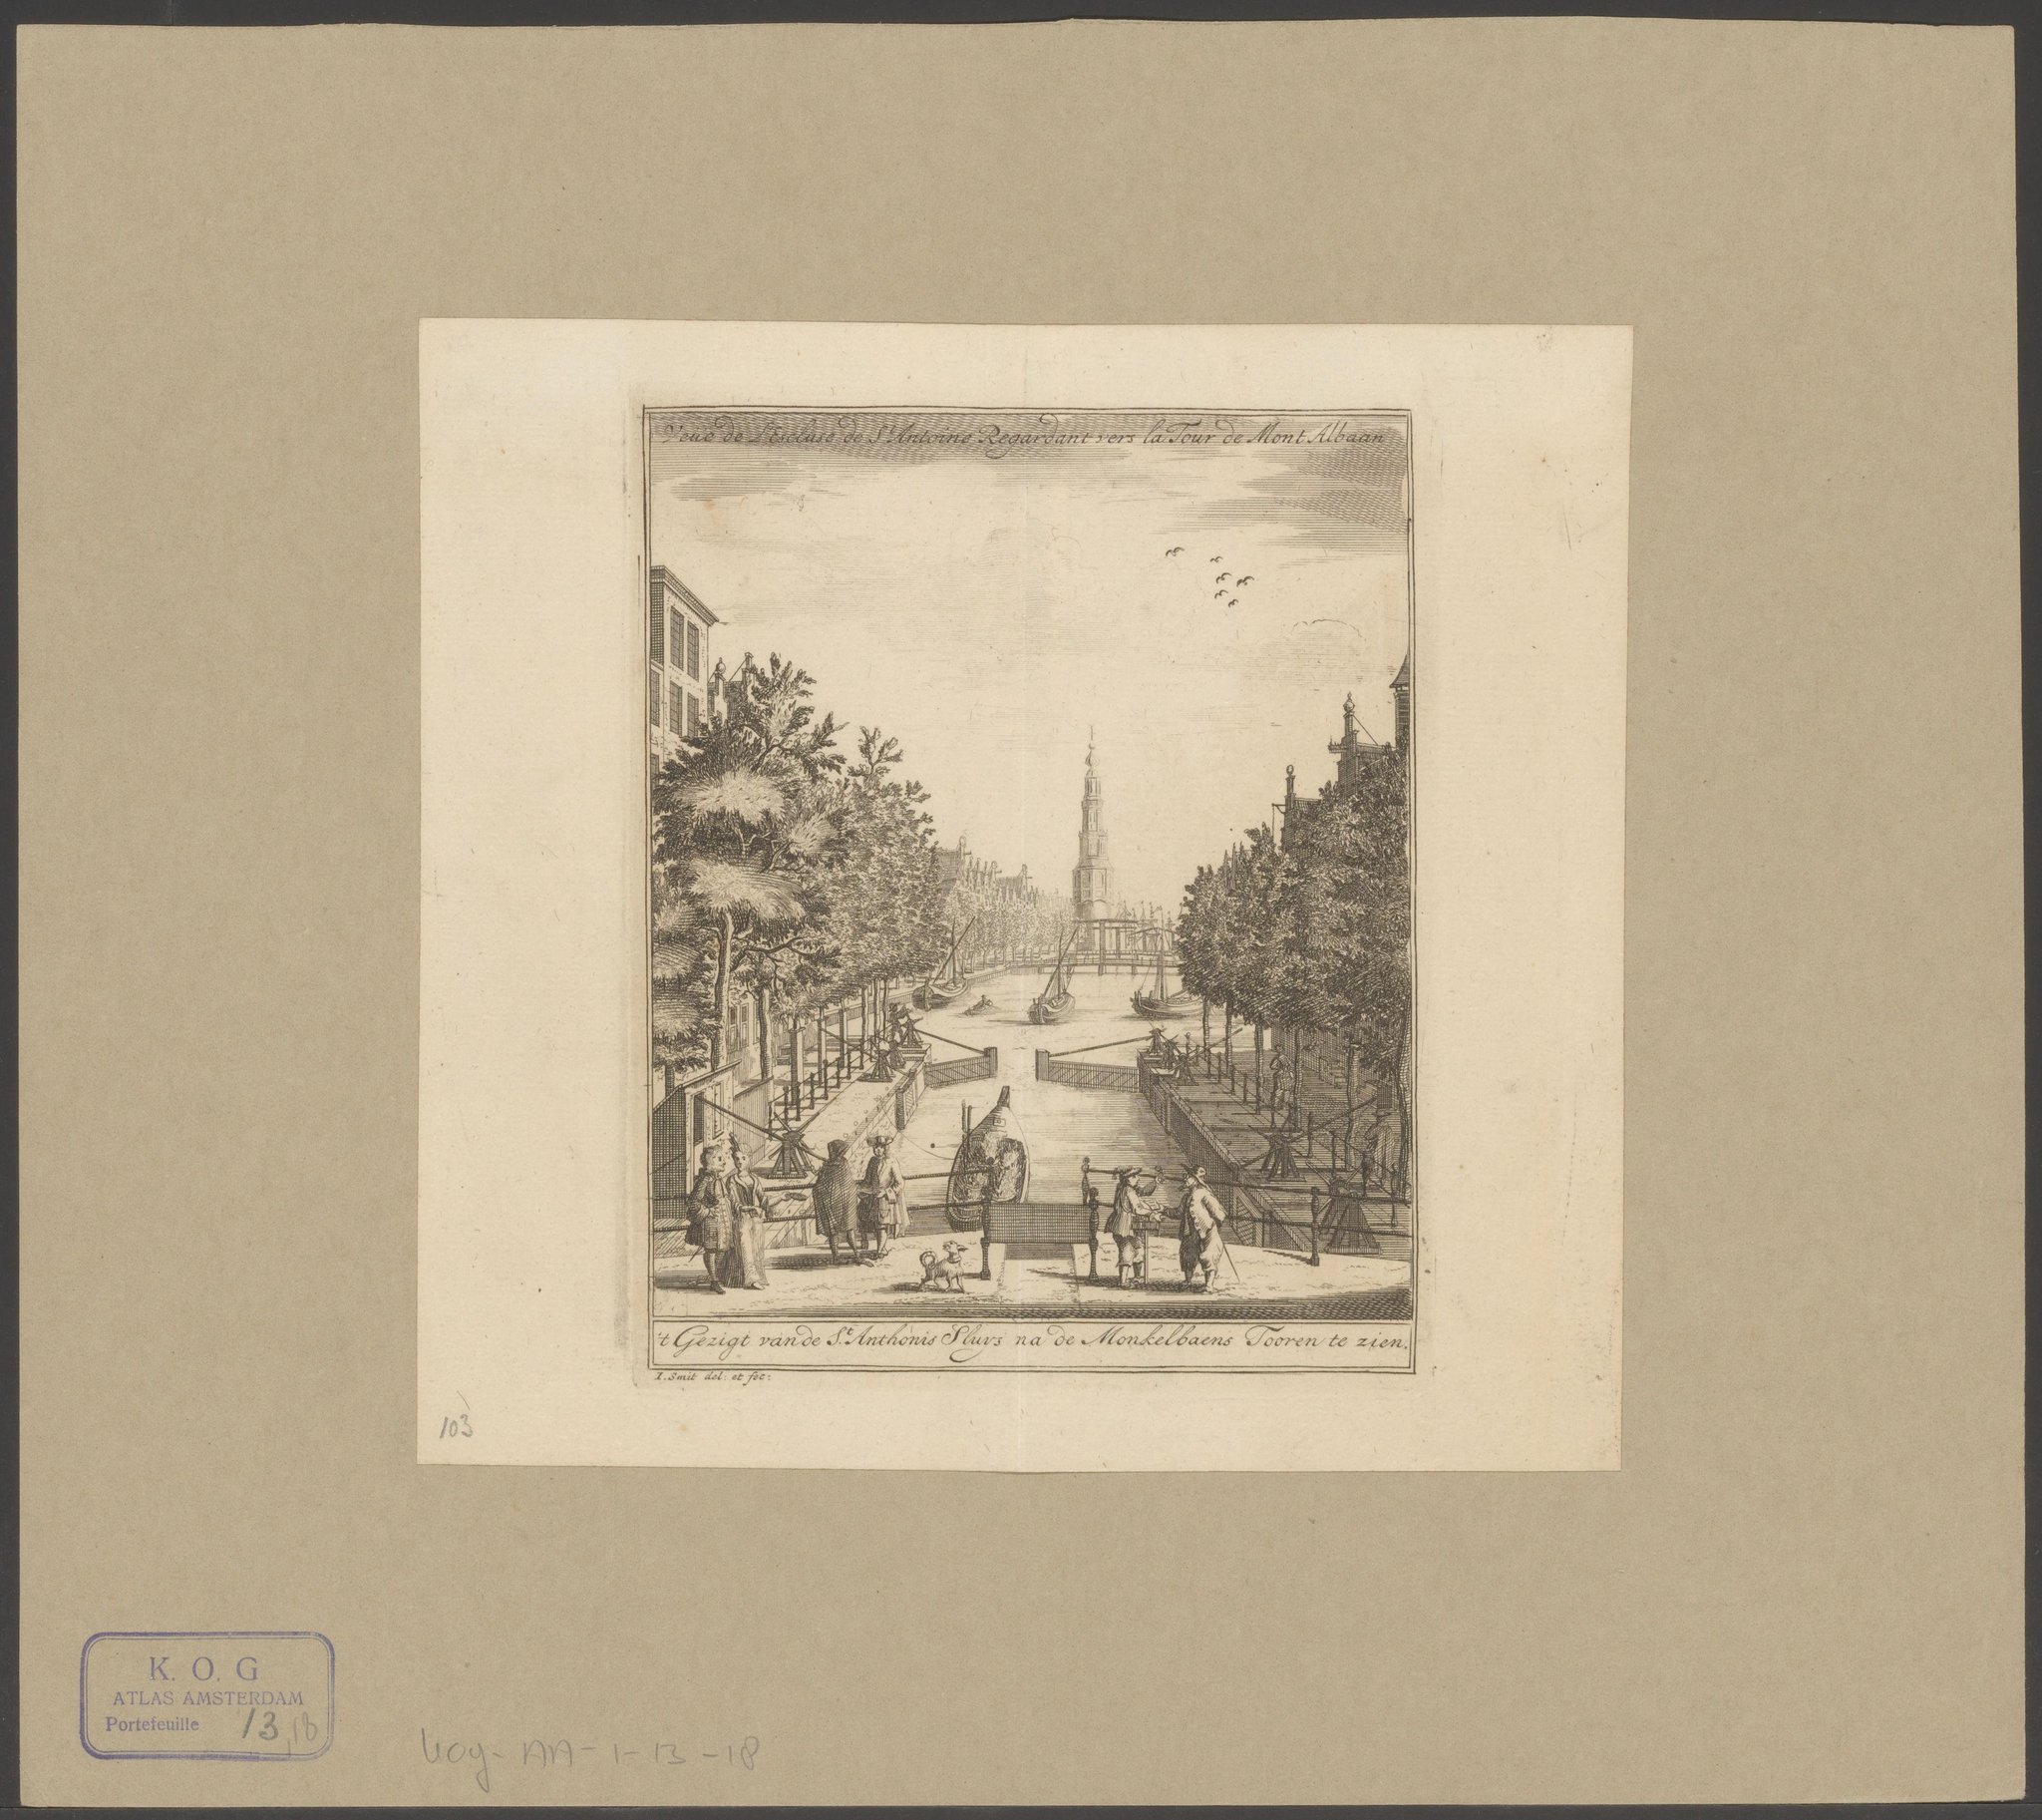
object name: print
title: 't Gezigt van de St. Anthonis Sluys na de Monkelbaens Tooren te zien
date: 1685-1768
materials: paper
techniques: engraving, etching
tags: sluice, weir, tower, clock tower ~ monumental adornment, city-view in general; 'veduta', canal, the usual house or row of houses, bridge in city across river, canal, etc., boat propelled by man or animal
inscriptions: collector's mark: ‘13,18’ Lugt 1641b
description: Onderwerpsrubriek binnen de Atlas Amsterdam: Oude Schans, Schoutensteeg, Singel (Korte), Singel.